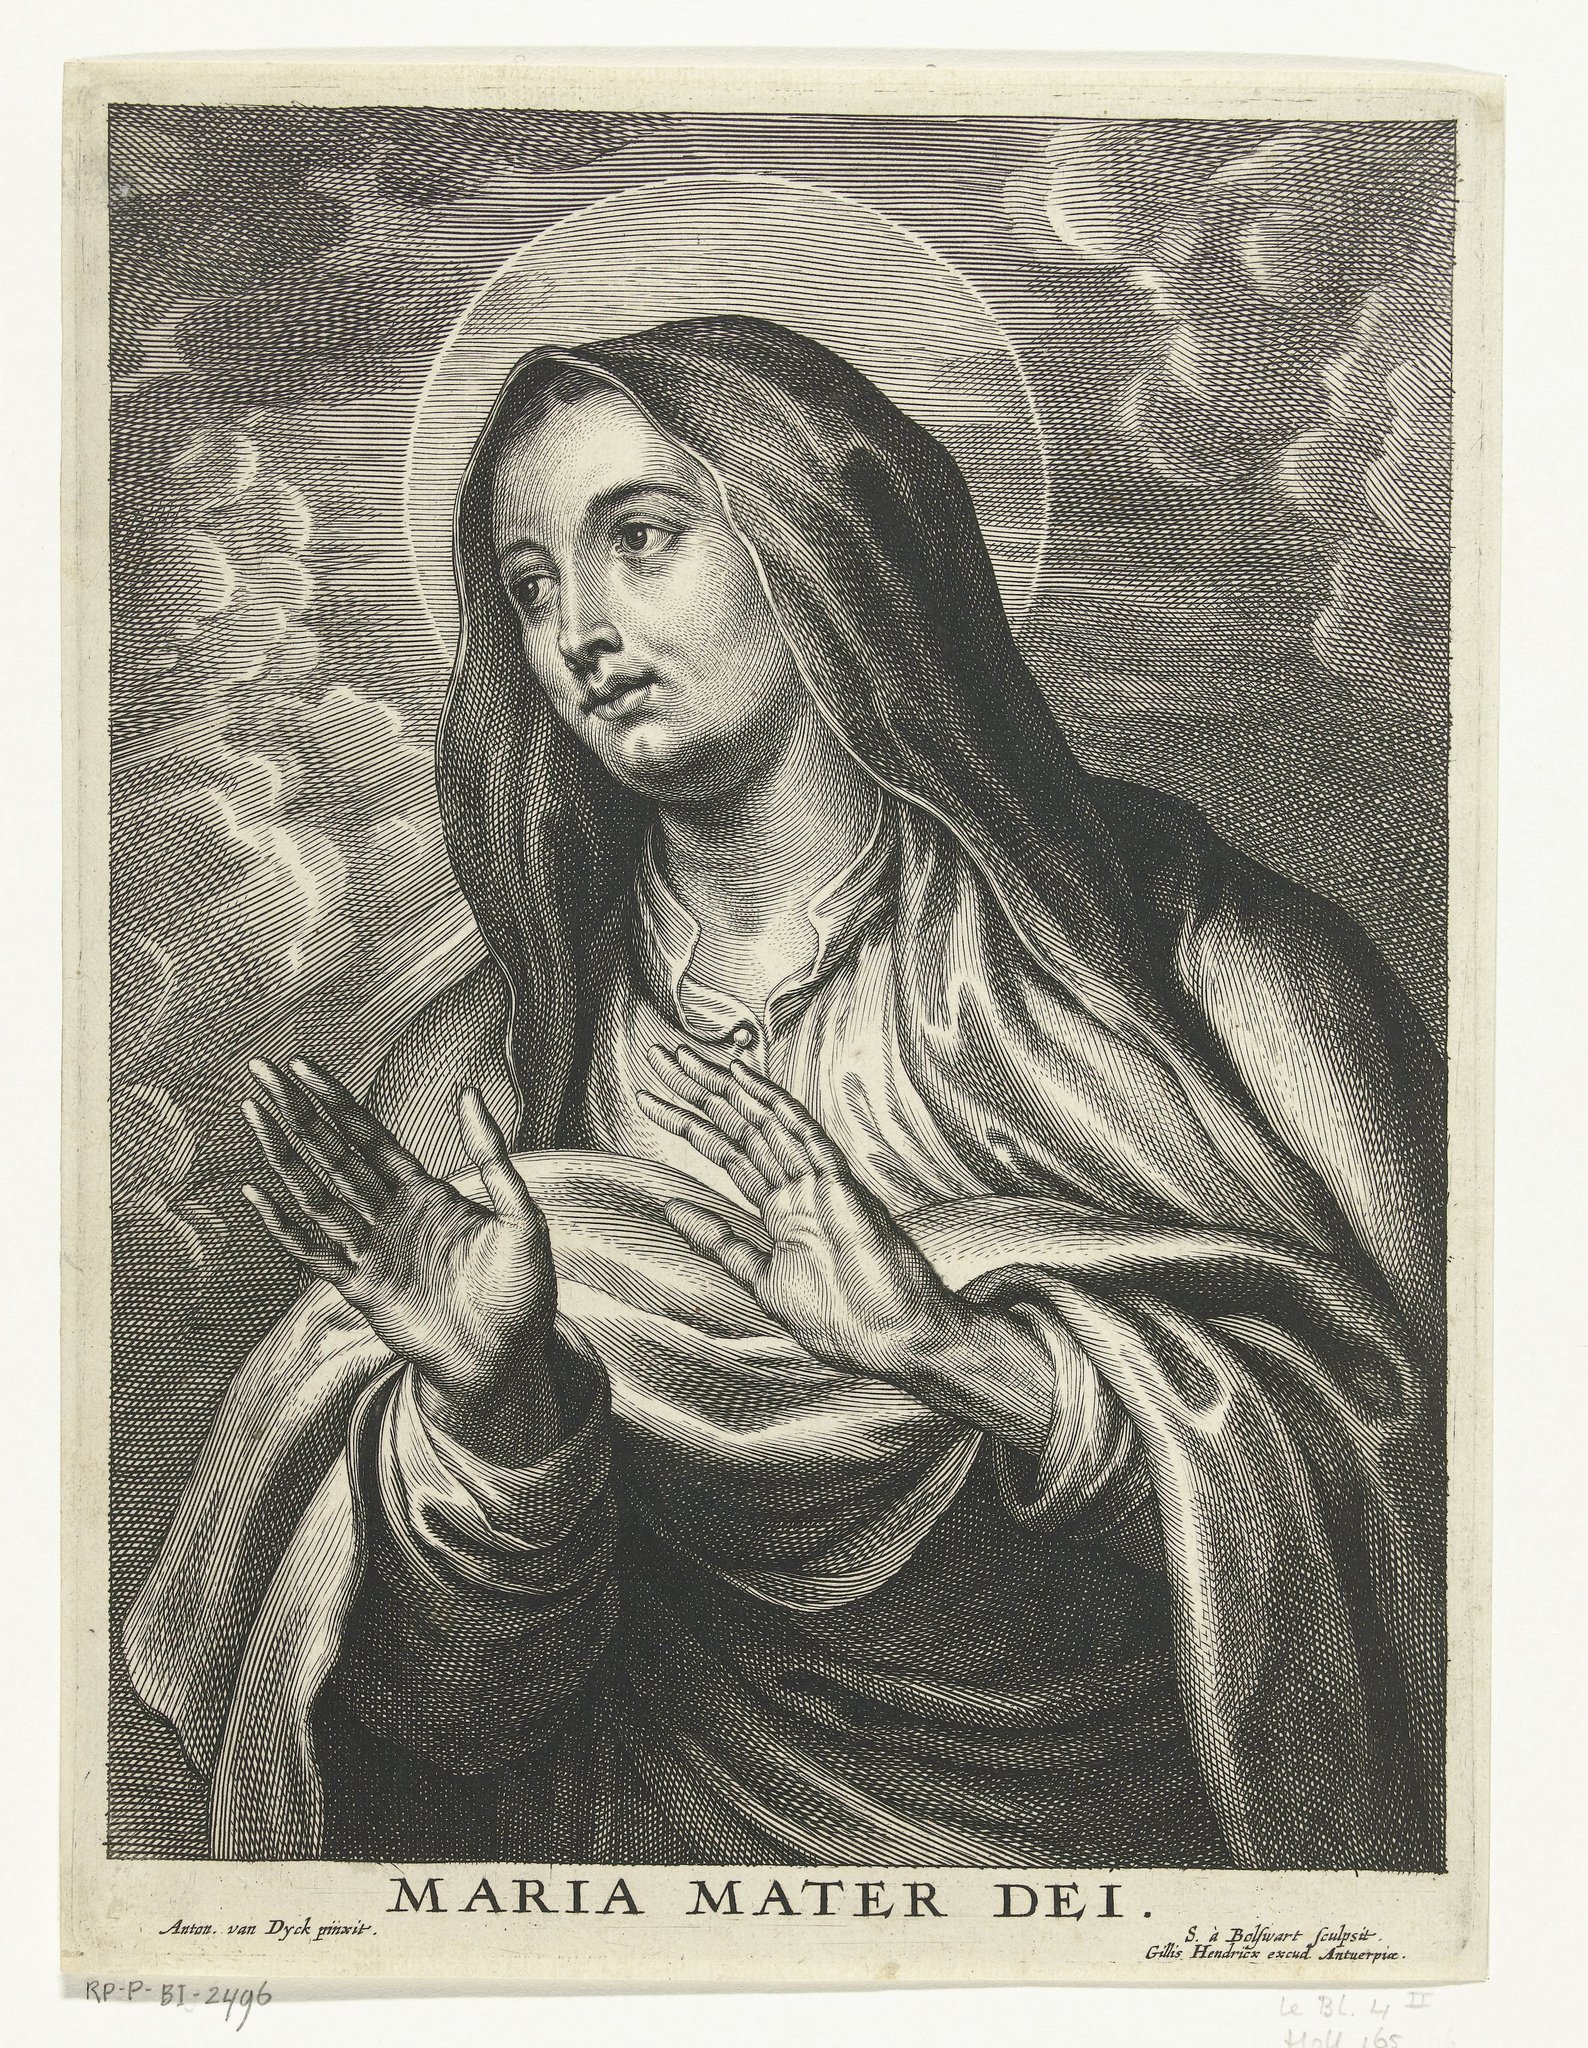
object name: print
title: Maria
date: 1596-1659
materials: paper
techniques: engraving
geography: antwerp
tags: mary as orante (sometimes called 'blacherniotissa')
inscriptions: collector's mark: Lugt 240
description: Maria staat in orante houding naar links gewend met haar blik gericht naar haar zoon die op de tegenhanger van deze prent is afgebeeld: Christus als Salvator Mundi.